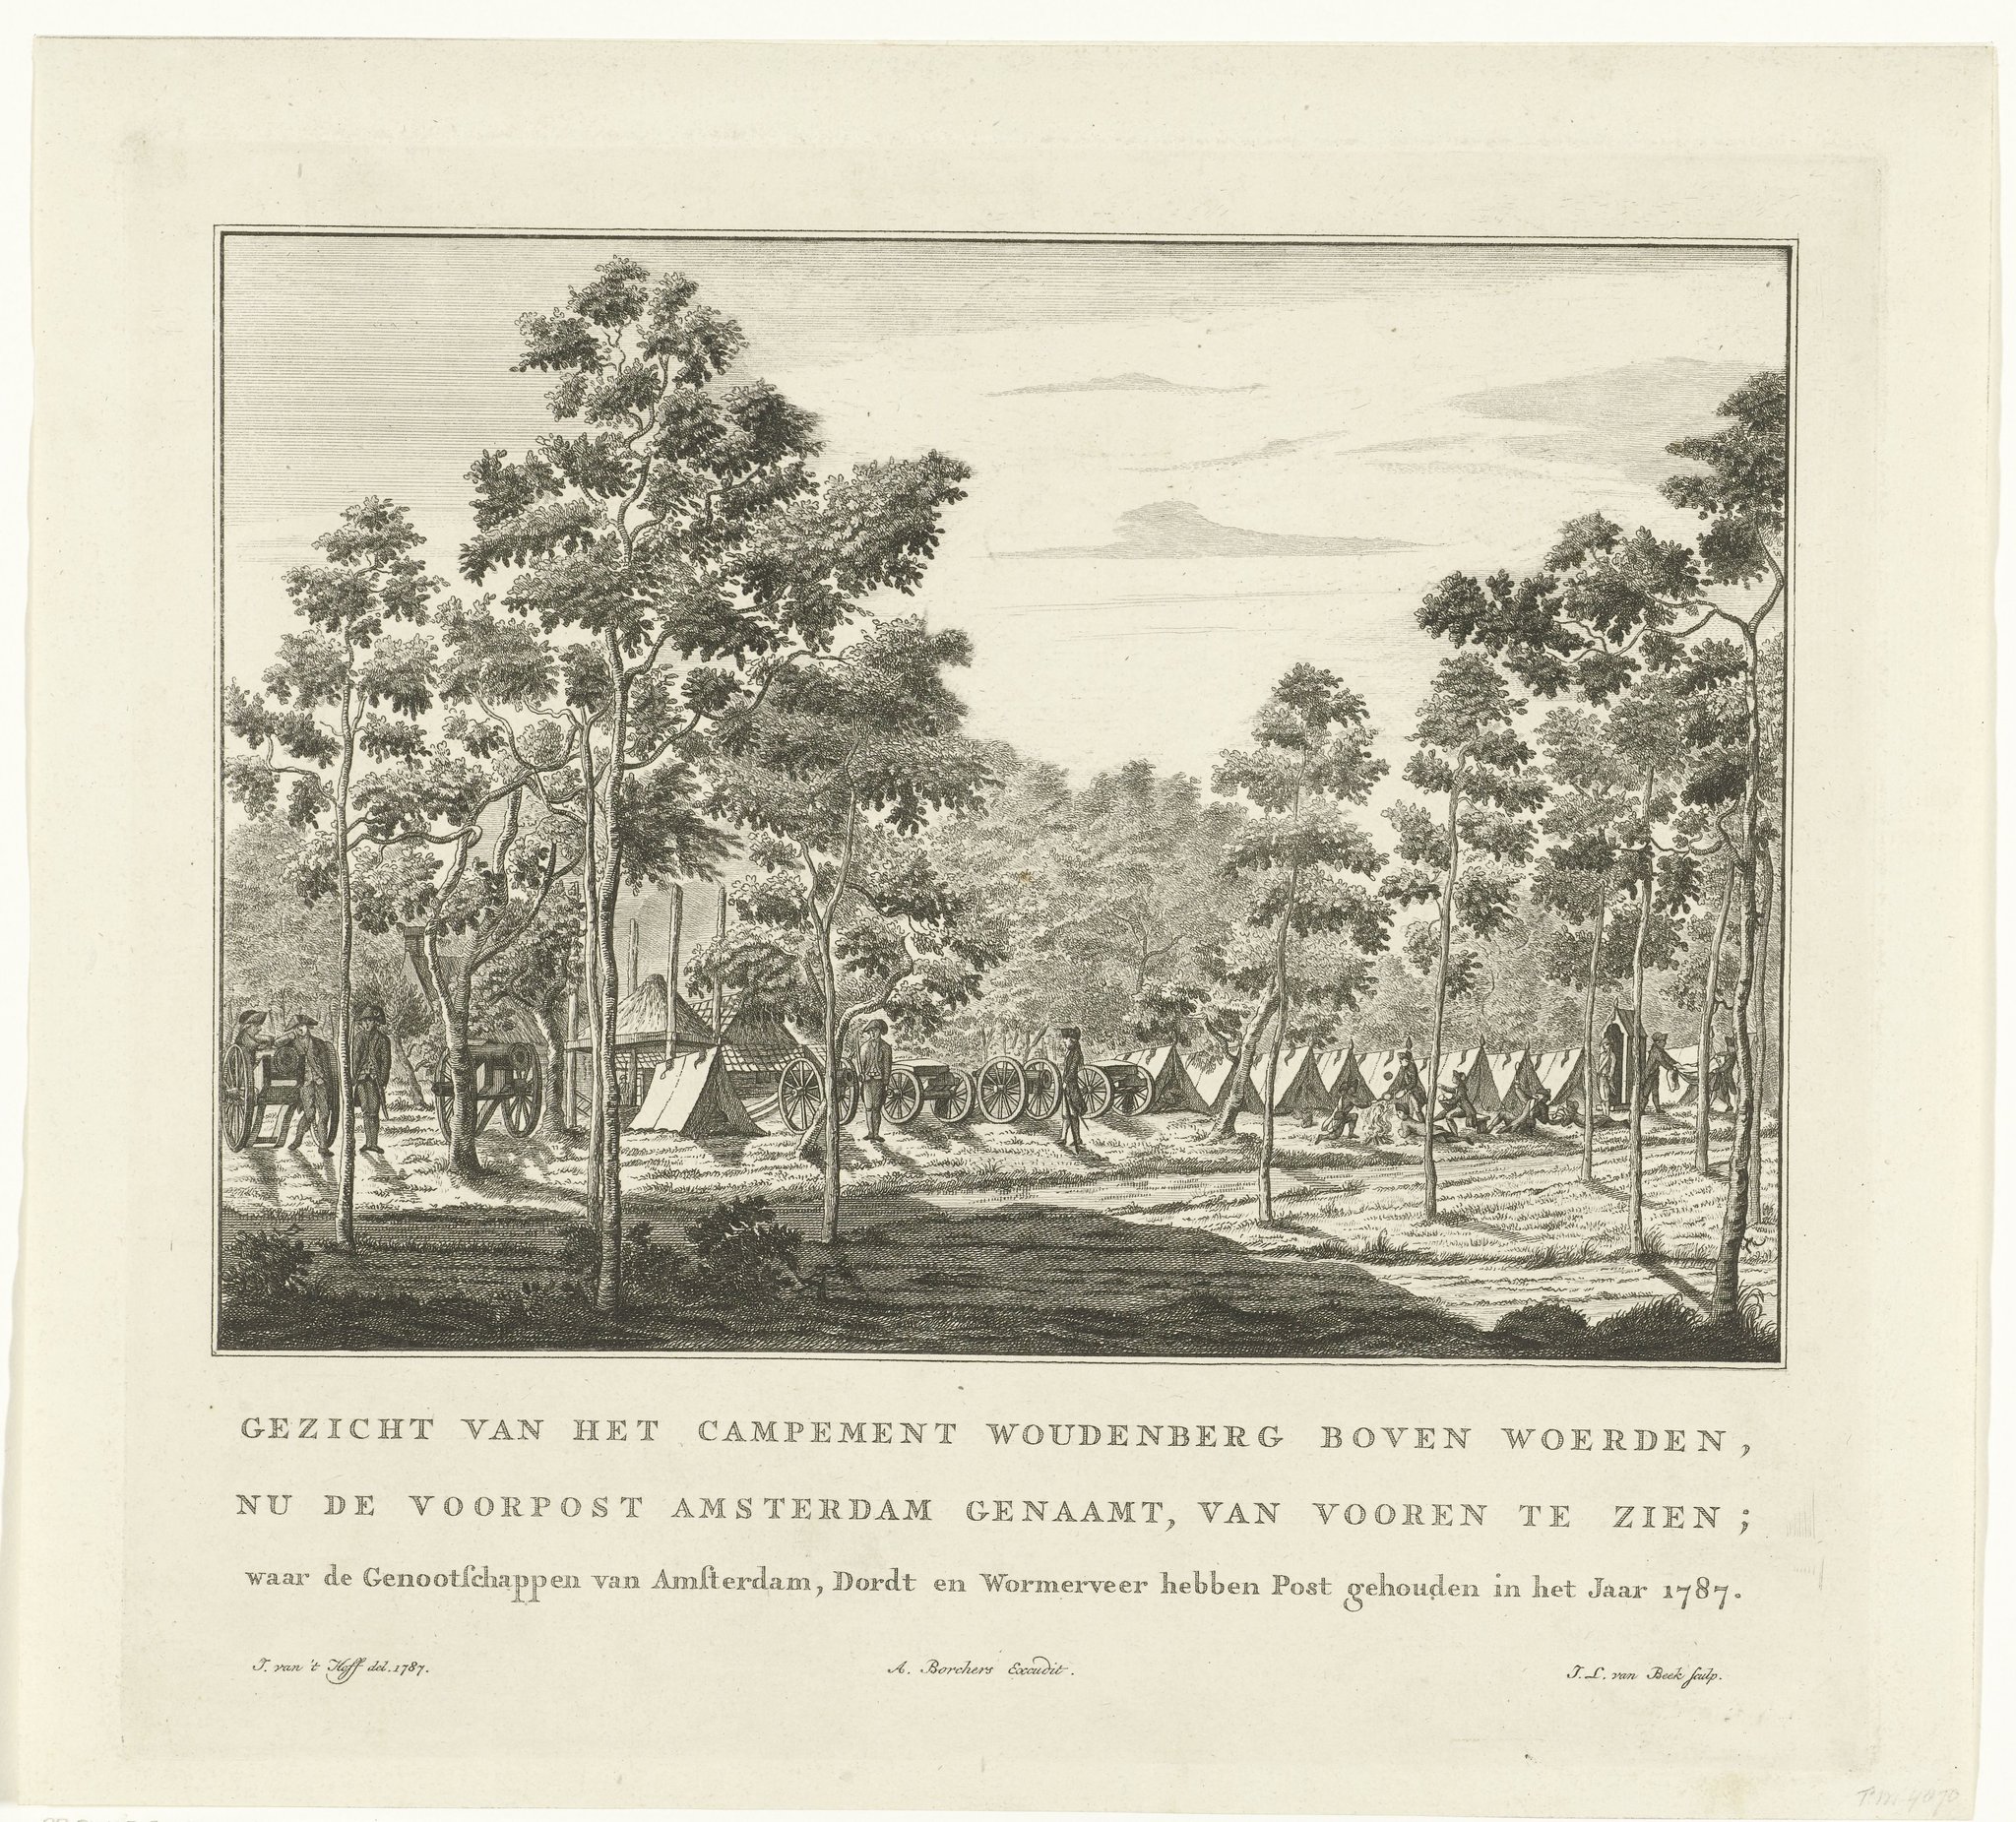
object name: print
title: Gezicht van het campement Woudenberg boven Woerden, nu de Voorpost Amsterdam genaamt, van vooren te zien; waar de Genootschappen van Amsterdam, Dordt en Wormerveer hebben post gehouden in het jaar 1787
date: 1787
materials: paper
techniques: etching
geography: northern netherlands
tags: (military) camp with tents, patriots (1780-1795)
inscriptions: collector's mark: Lugt 2228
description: Kampement Woudenberg of Voorpost Amsterdam, bij Woerden, waar de burgerkorpsen van Amsterdam, Dordrecht en Wormerveer hun tenten opgeslagen en kanonnen opgesteld hebben, 3-4 augustus 1787. Gezicht op het kampement van voren. Bij de prent hoort een pendant.